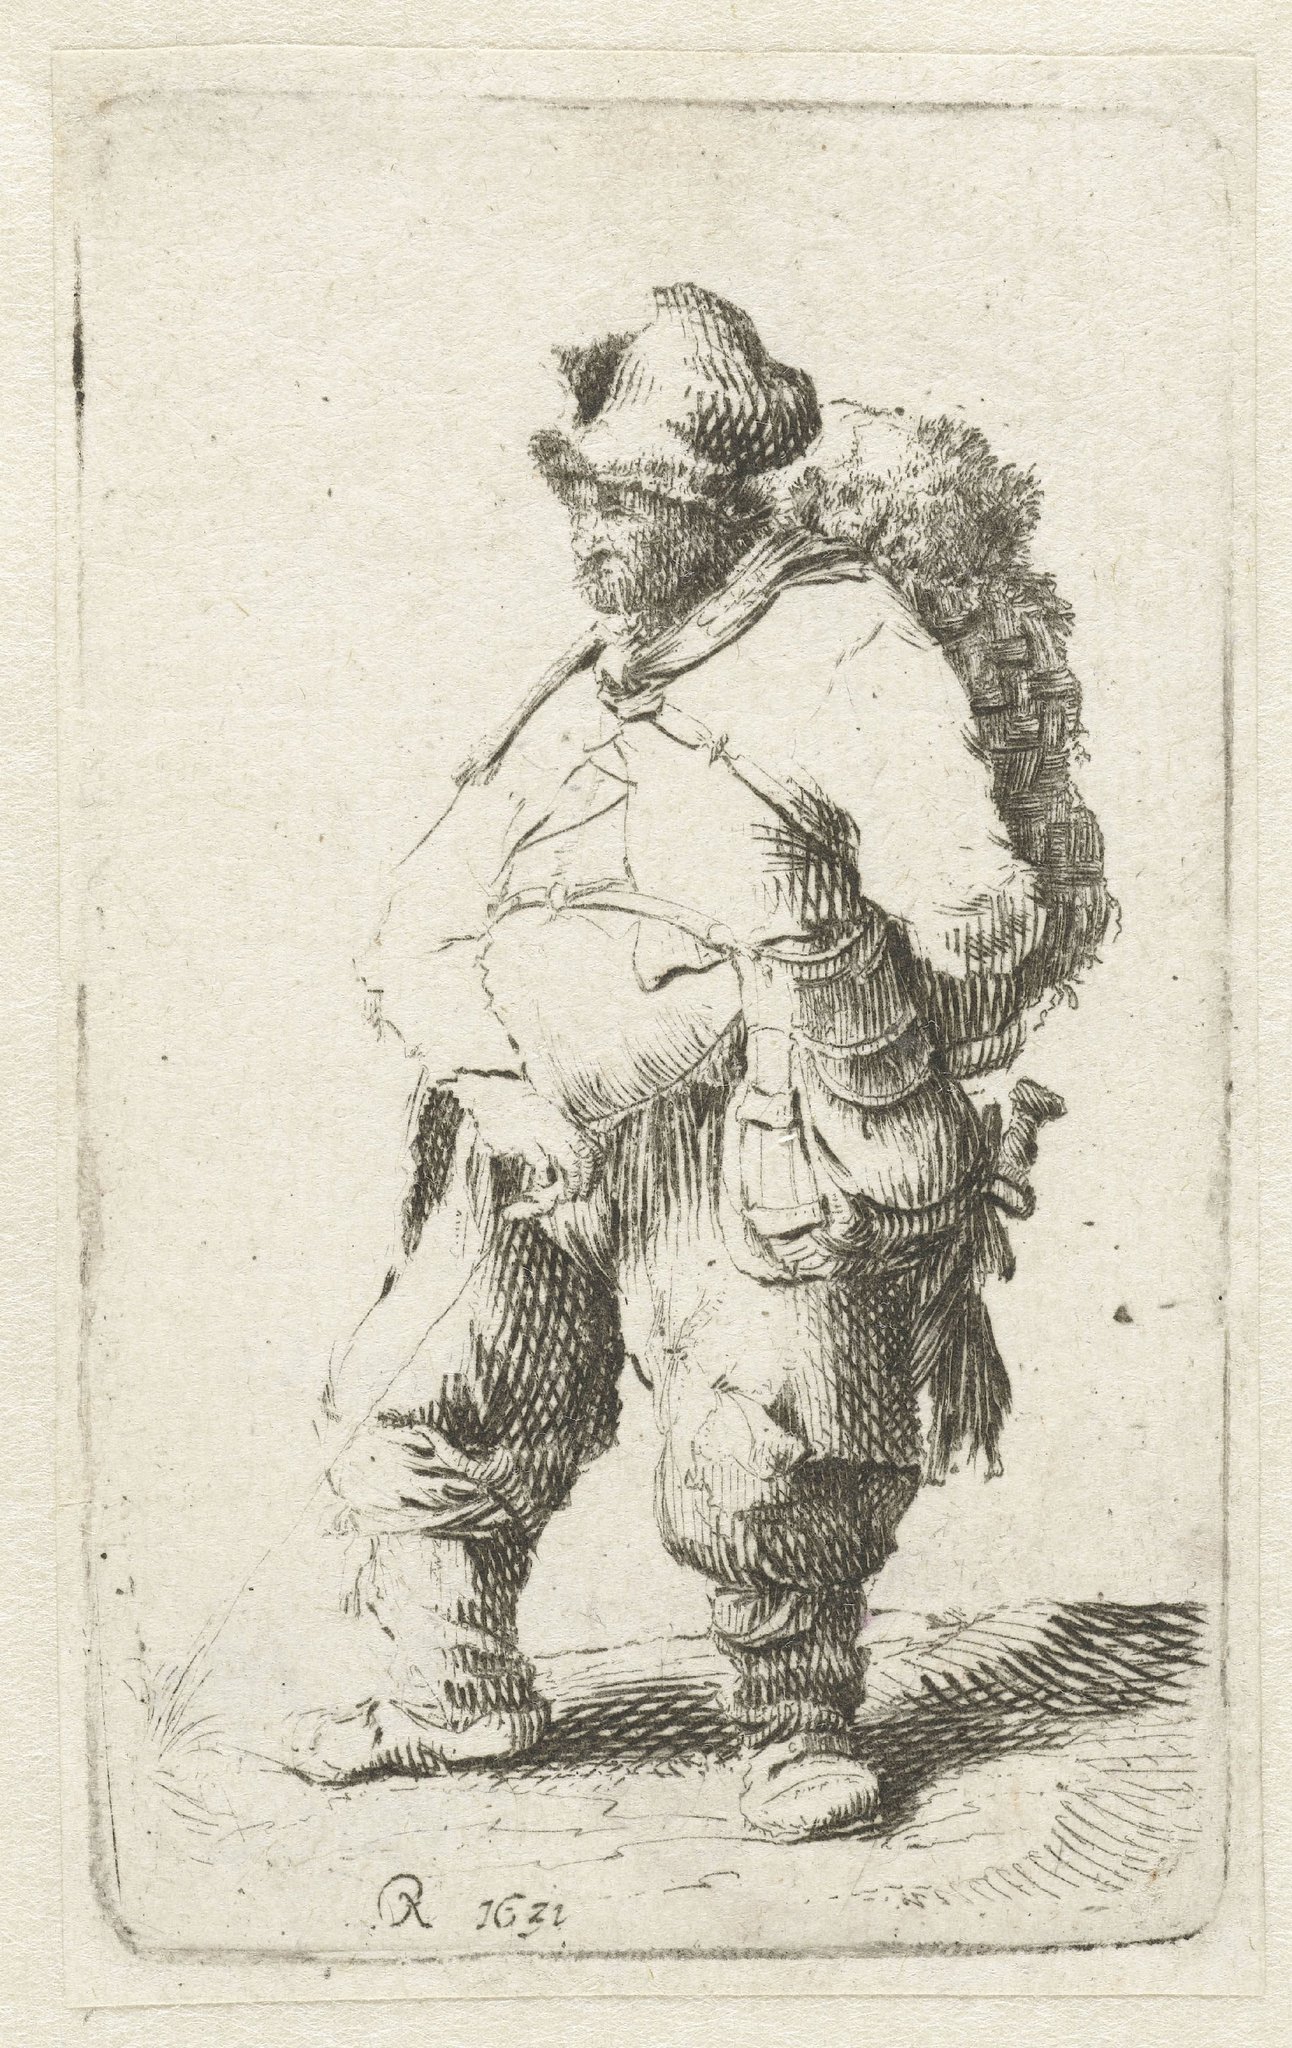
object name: print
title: A man making water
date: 1630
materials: paper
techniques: etching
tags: urination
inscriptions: collector's mark: Lugt 240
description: Spiegelbeeldige kopie naar de gelijknamige prent van Rembrandt.